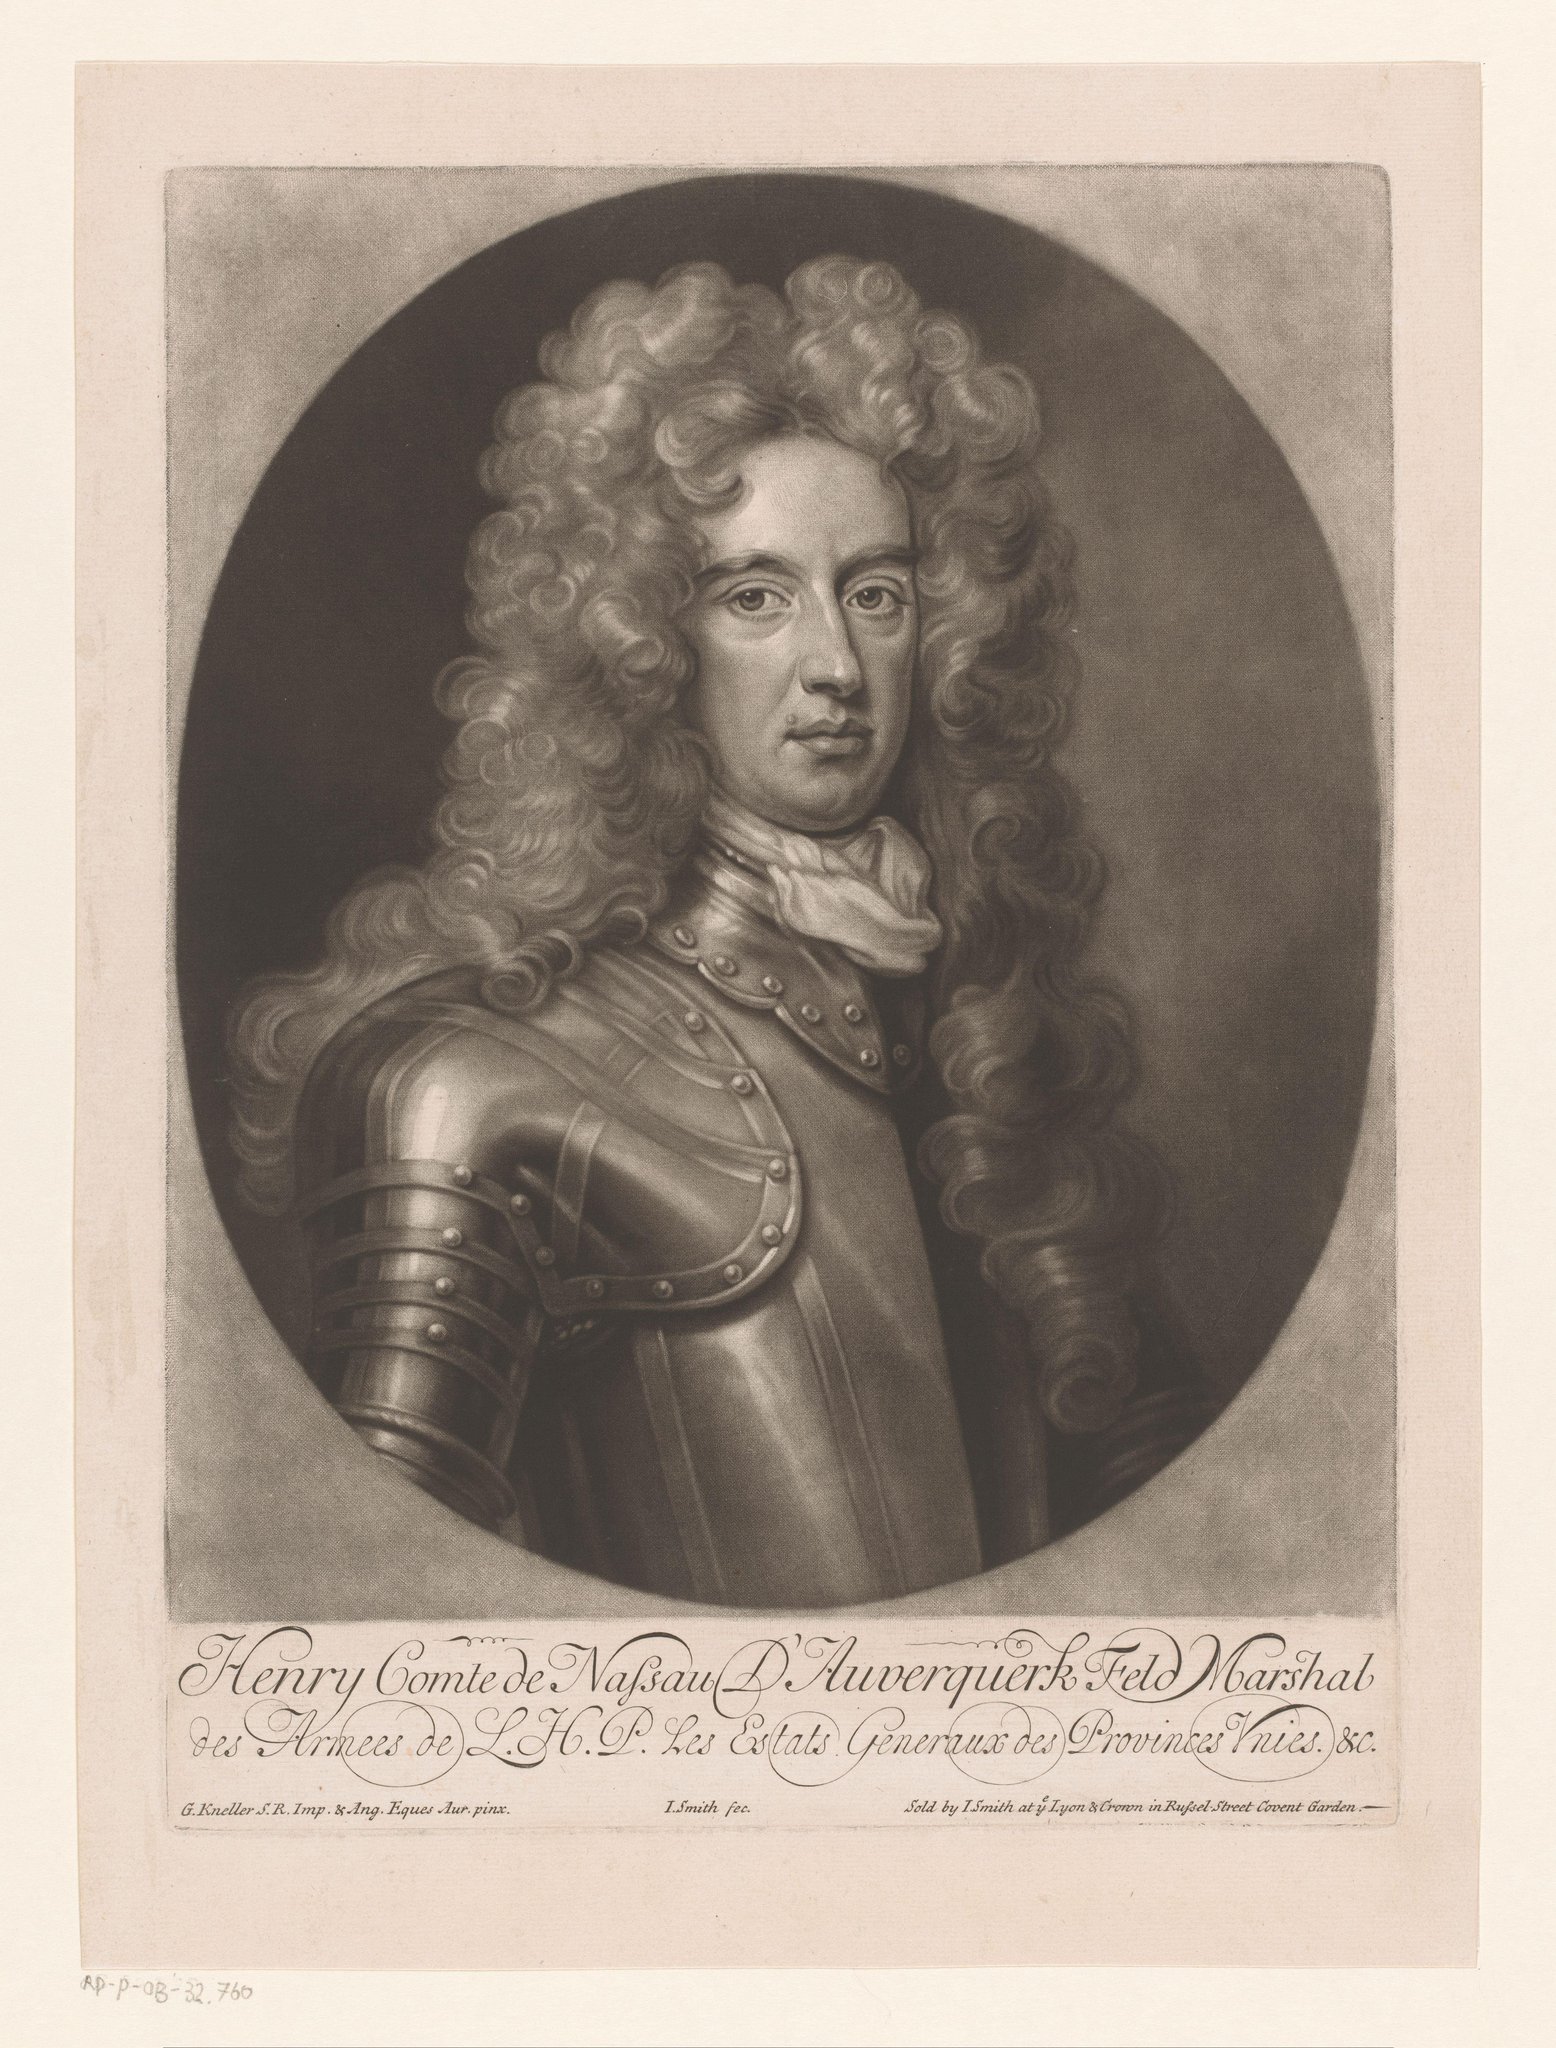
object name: print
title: Henry Comte de Nassau D'Auverquerk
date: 1662-1742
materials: paper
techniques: mezzotint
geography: london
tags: the hague, commander-in-chief, general, marshal, historical persons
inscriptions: collector's mark: Lugt 240